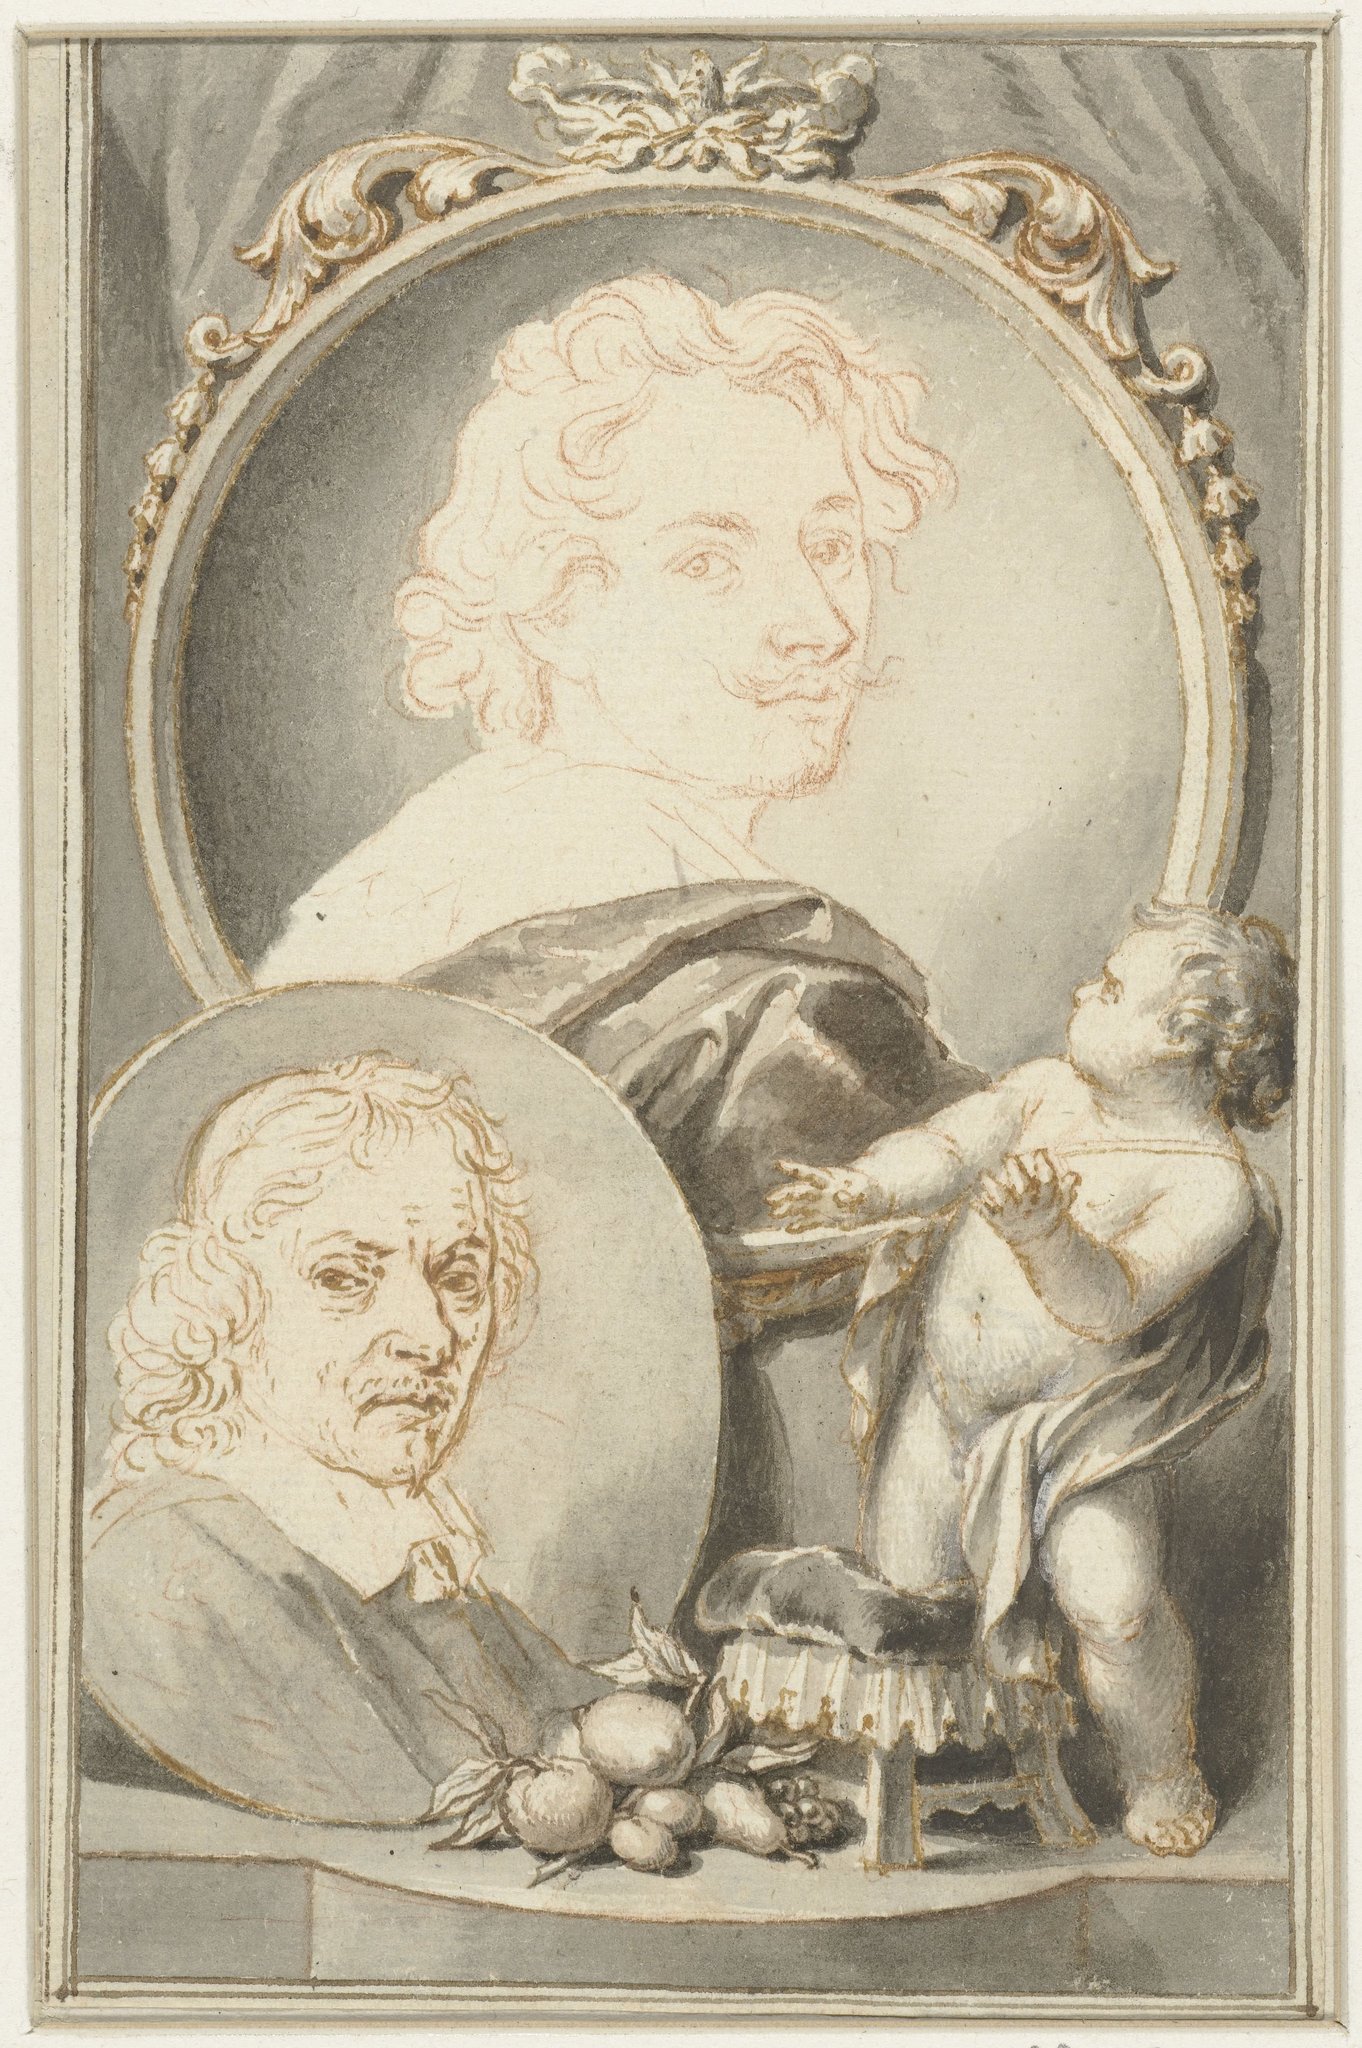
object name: design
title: Portretten van Anton van Dyck en Jacob de Bray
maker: jacob houbraken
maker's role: draughtsman, print maker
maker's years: 1698-1780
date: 1708-1780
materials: chalk, ink, paper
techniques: brush, pen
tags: haarlem, antwerp, london, painter, print maker, draughtsman, anthony van dyck, historical persons, portrait, self-portrait of painter, portrait, self-portrait of artist